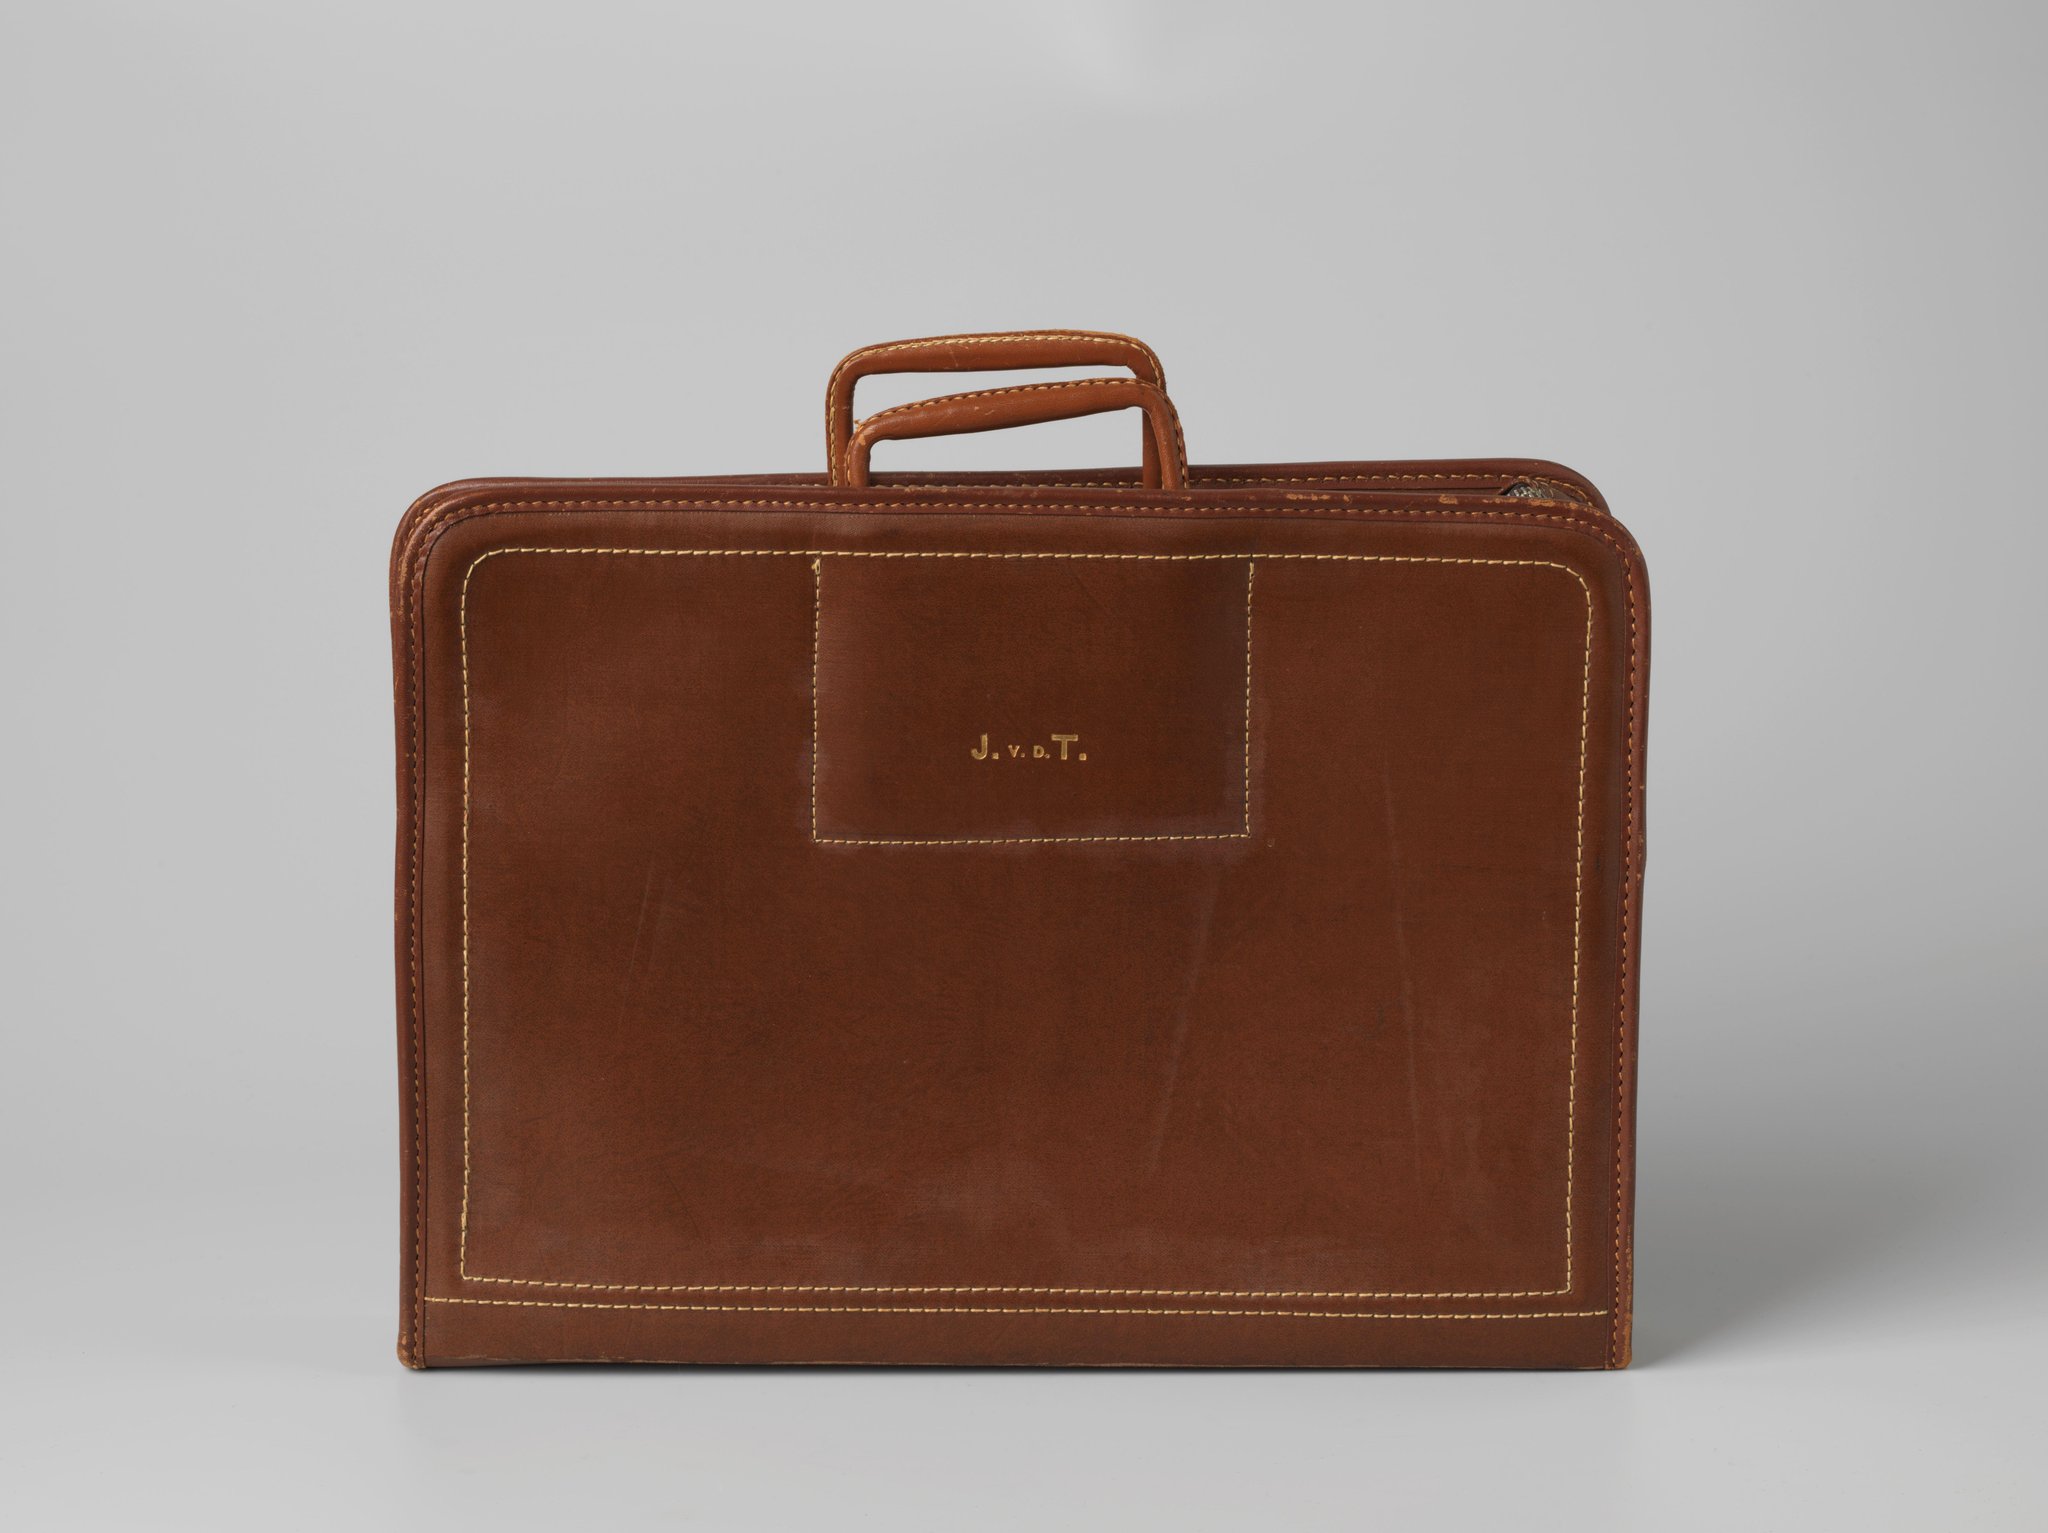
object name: aktetas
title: Aktetas van minister J. van den Tempel, geschonken door Koningin Wilhelmina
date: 1941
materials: leather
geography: great britain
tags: politician, london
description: Rechthoekige bruine tas met over 3 zijden een rits en 2 handgrepen aan de bovenzijde. Op een zijkant, m.b. in gestikt kader, in vergulde letters, de initialen van de eigenaar.